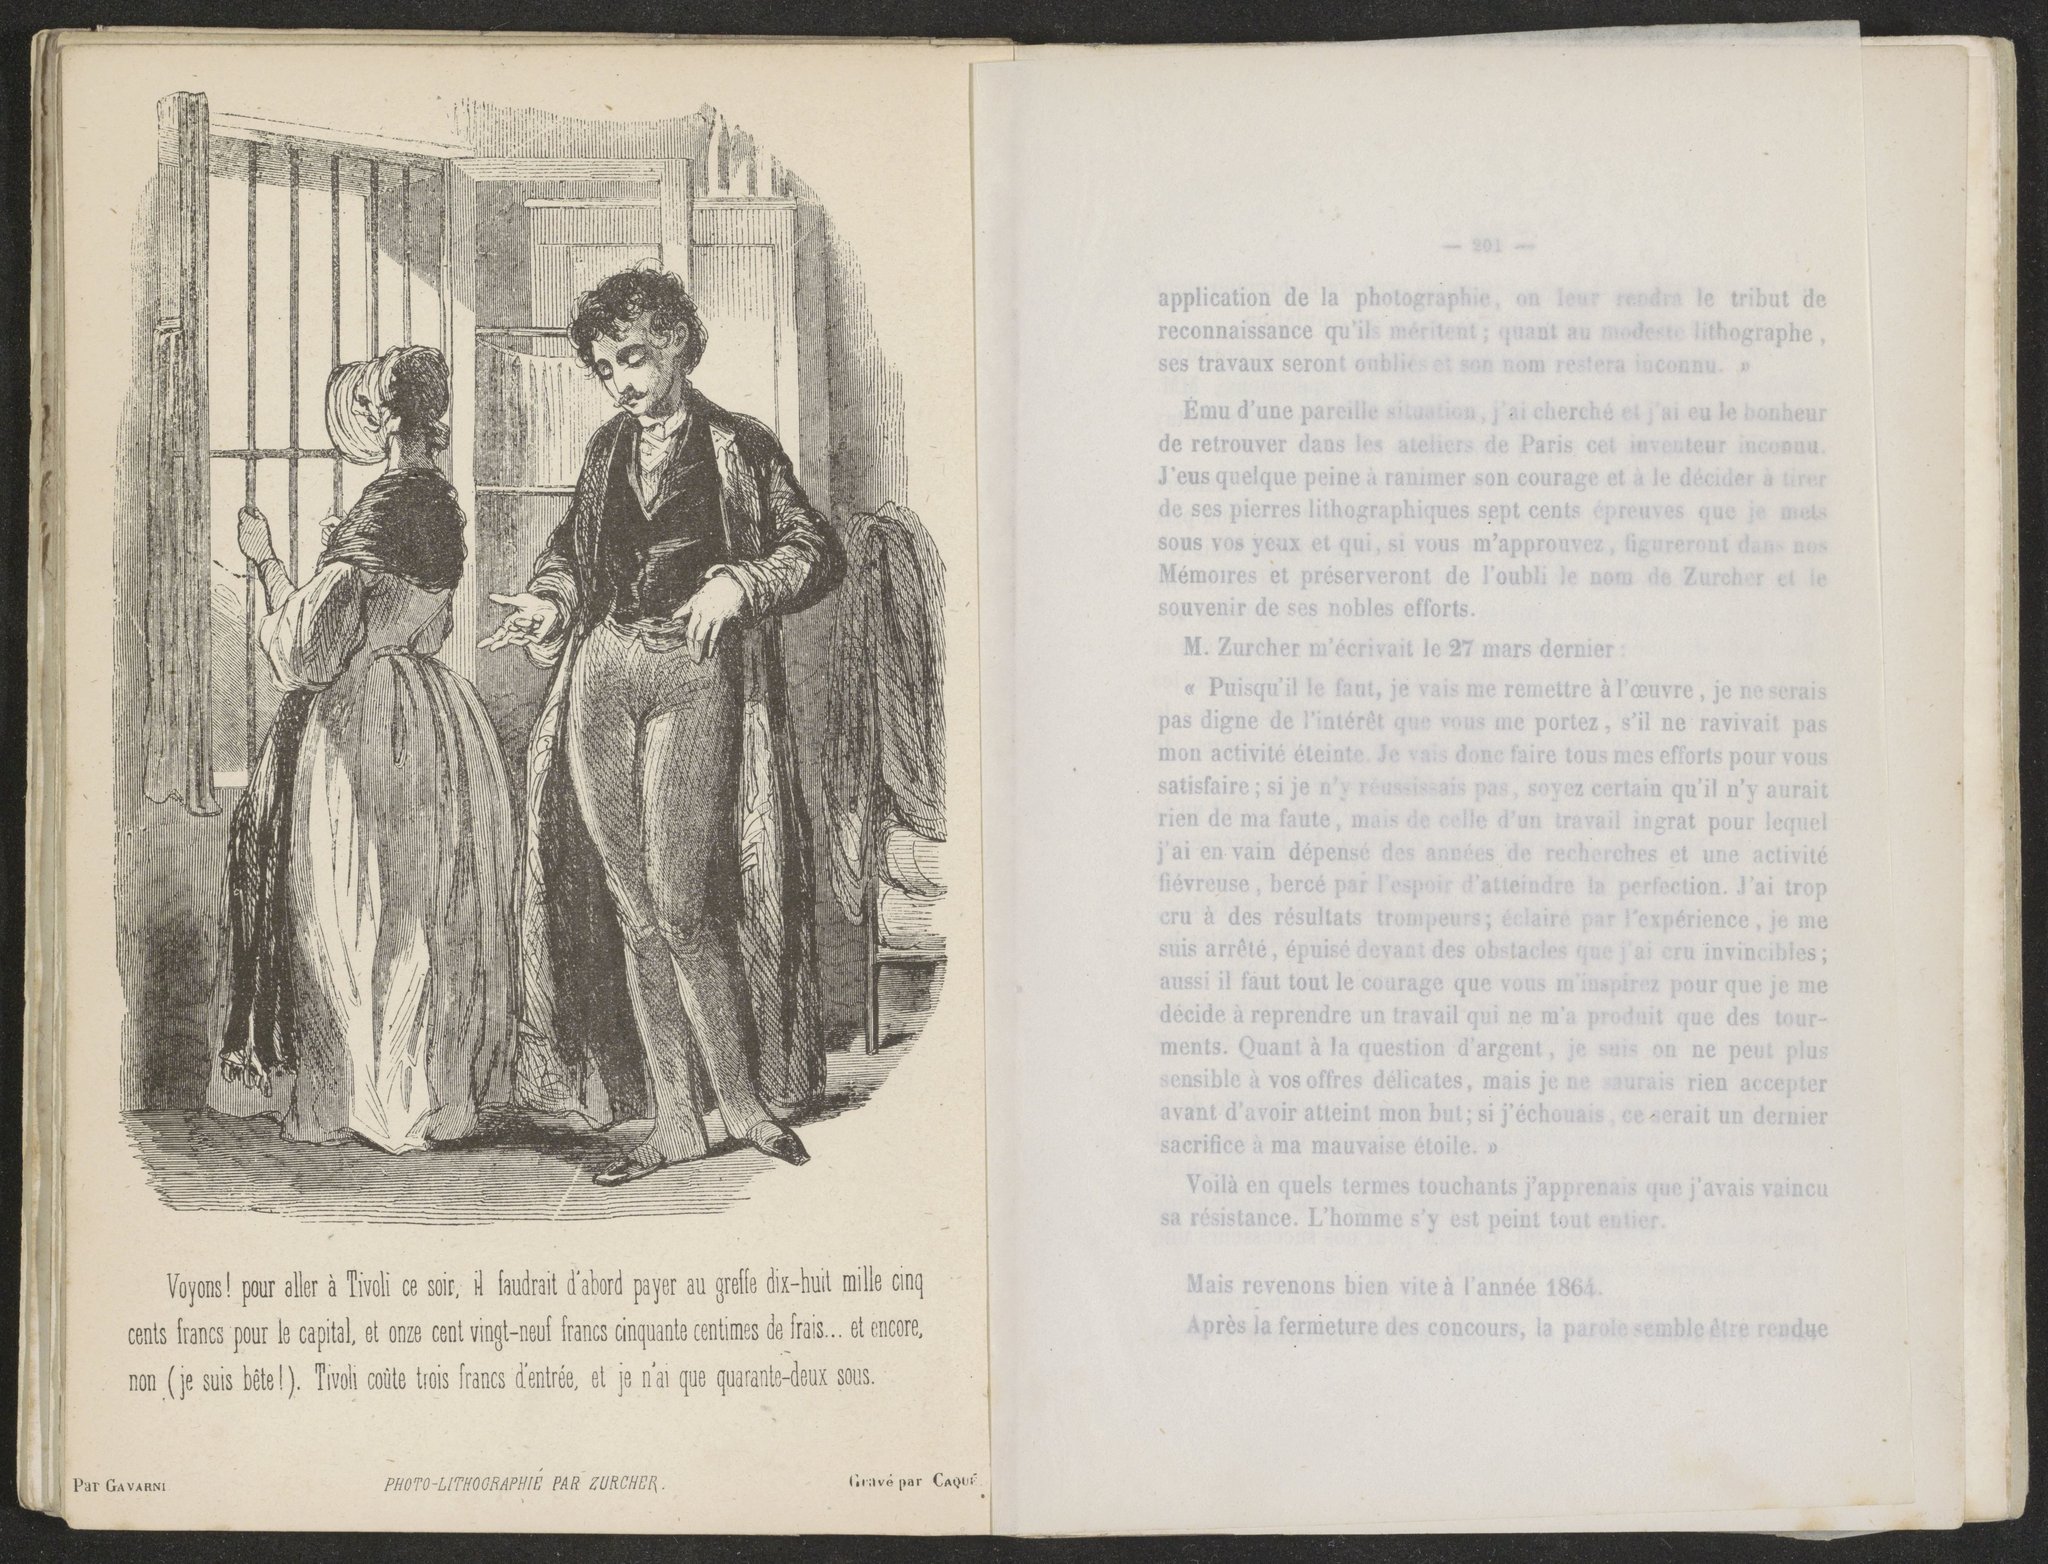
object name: page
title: Geld tellende man en een vrouw voor een raam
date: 1859-1869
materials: paper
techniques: photolithography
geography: france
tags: money, counting, calculating